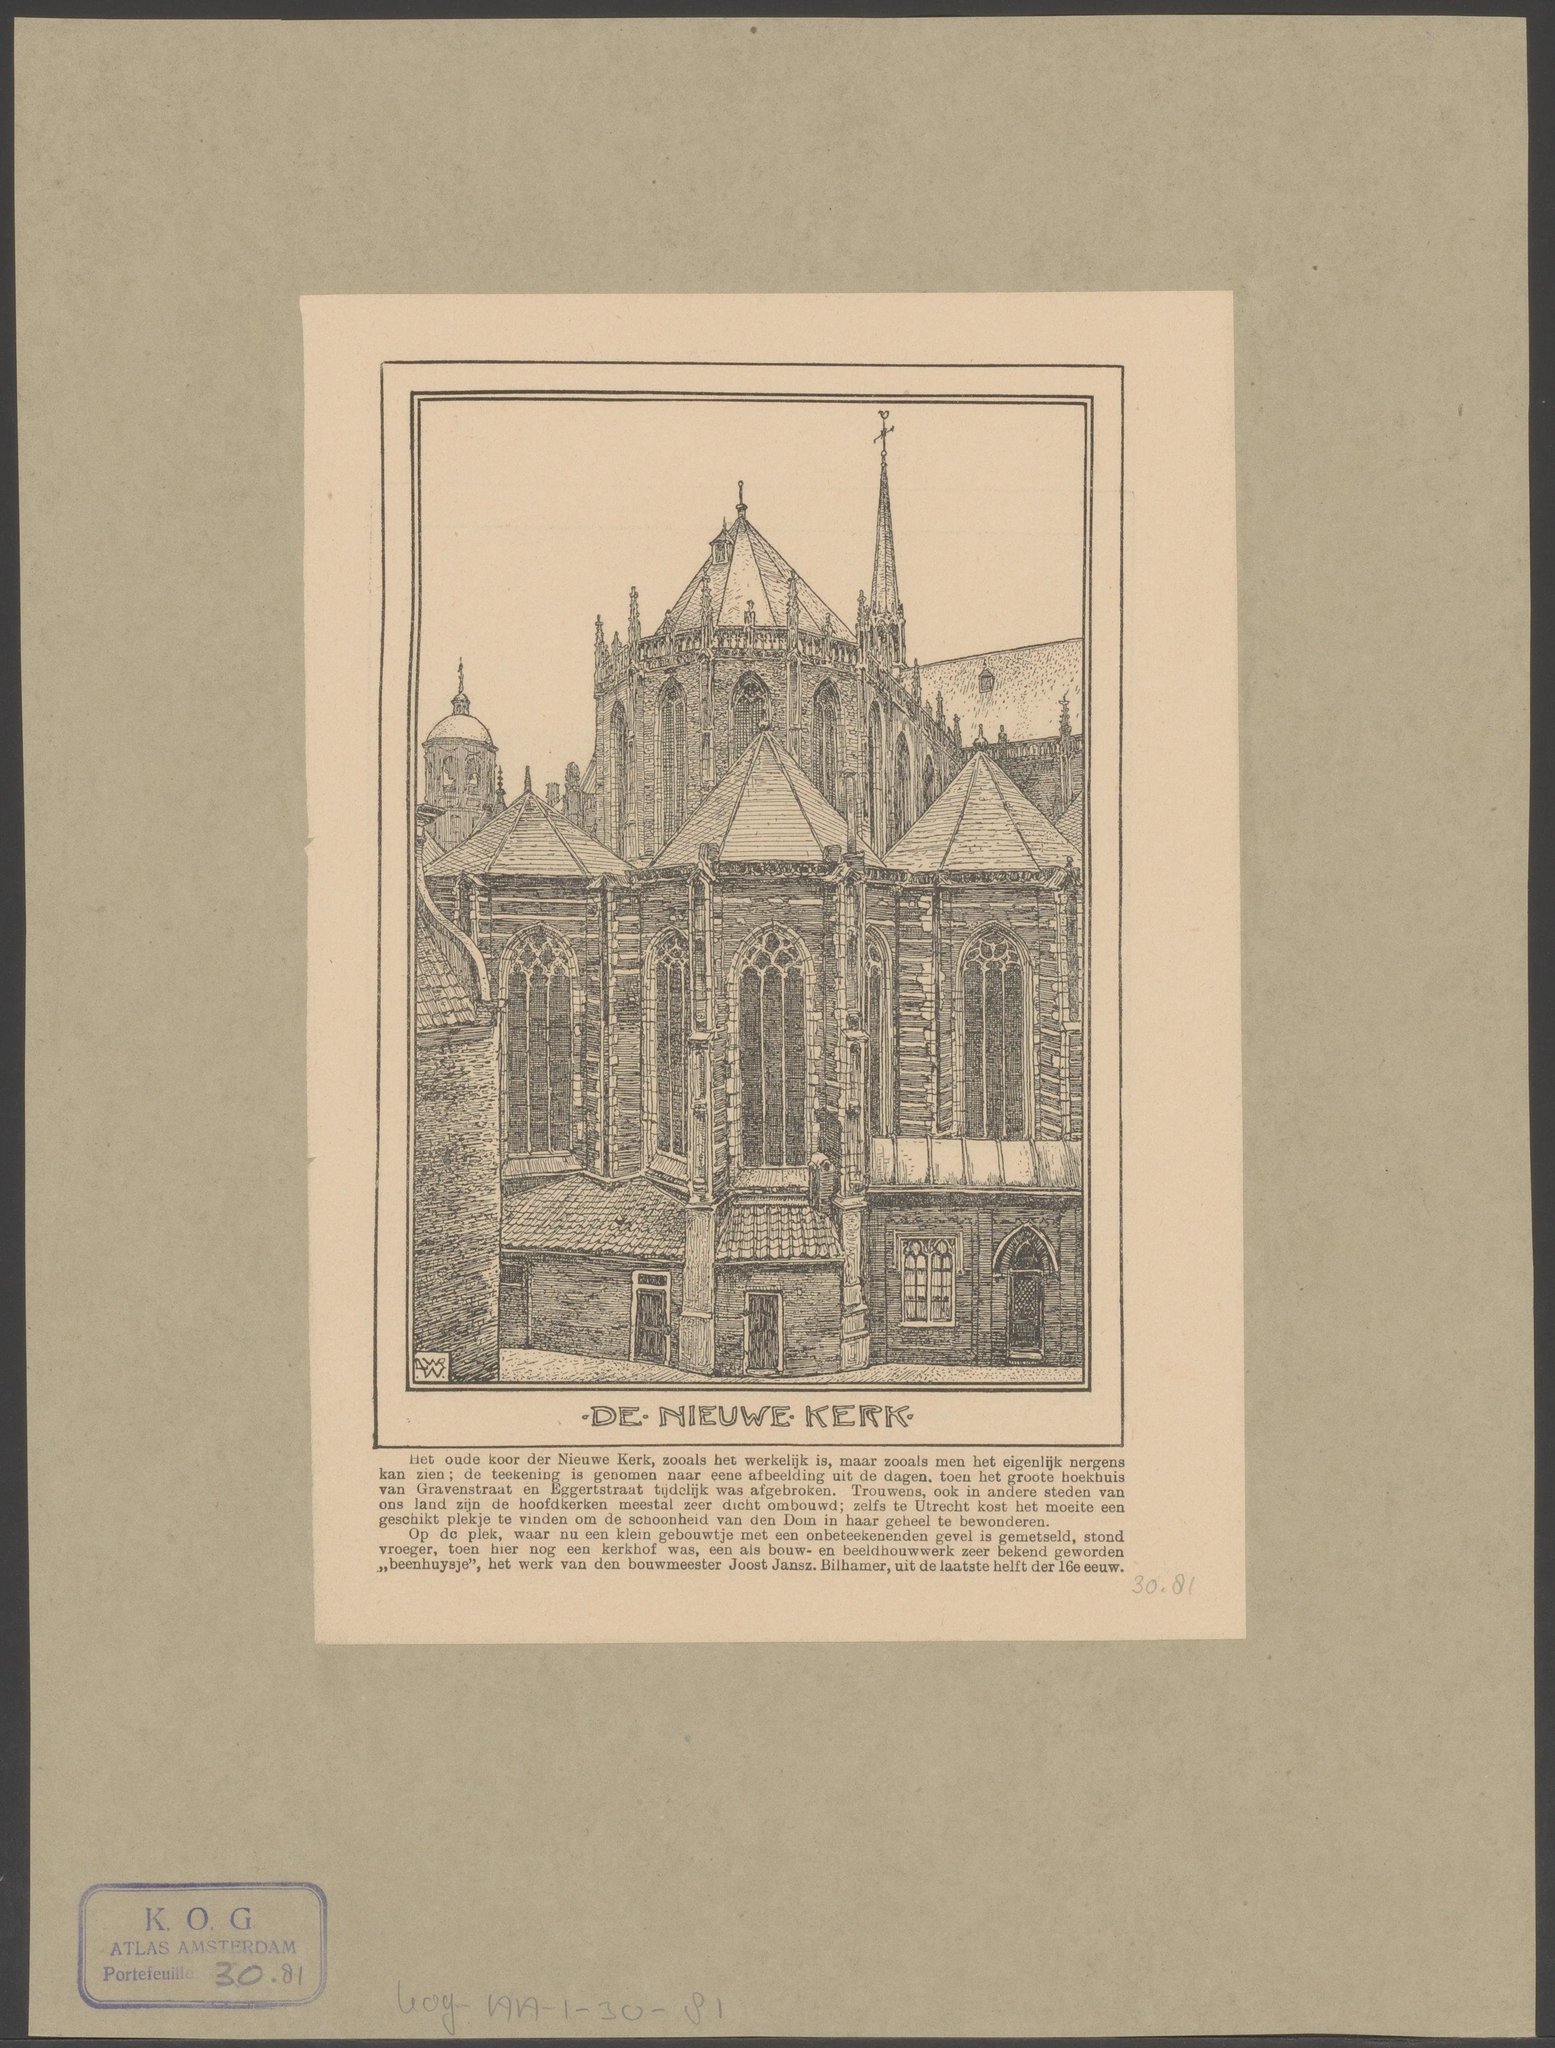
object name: photomechanical print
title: De Nieuwe Kerk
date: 1907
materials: paper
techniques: letterpress printing, line block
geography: amsterdam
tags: parts of church exterior and annexes: choir, church (exterior)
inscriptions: collector's mark: Lugt 1641b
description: Prent uit: Oud-Amsterdam. 100 stadsgezichten door L.W.R. Wenckebach. Amsterdam: Het Nieuws van den Dag, 1907, p. 3.